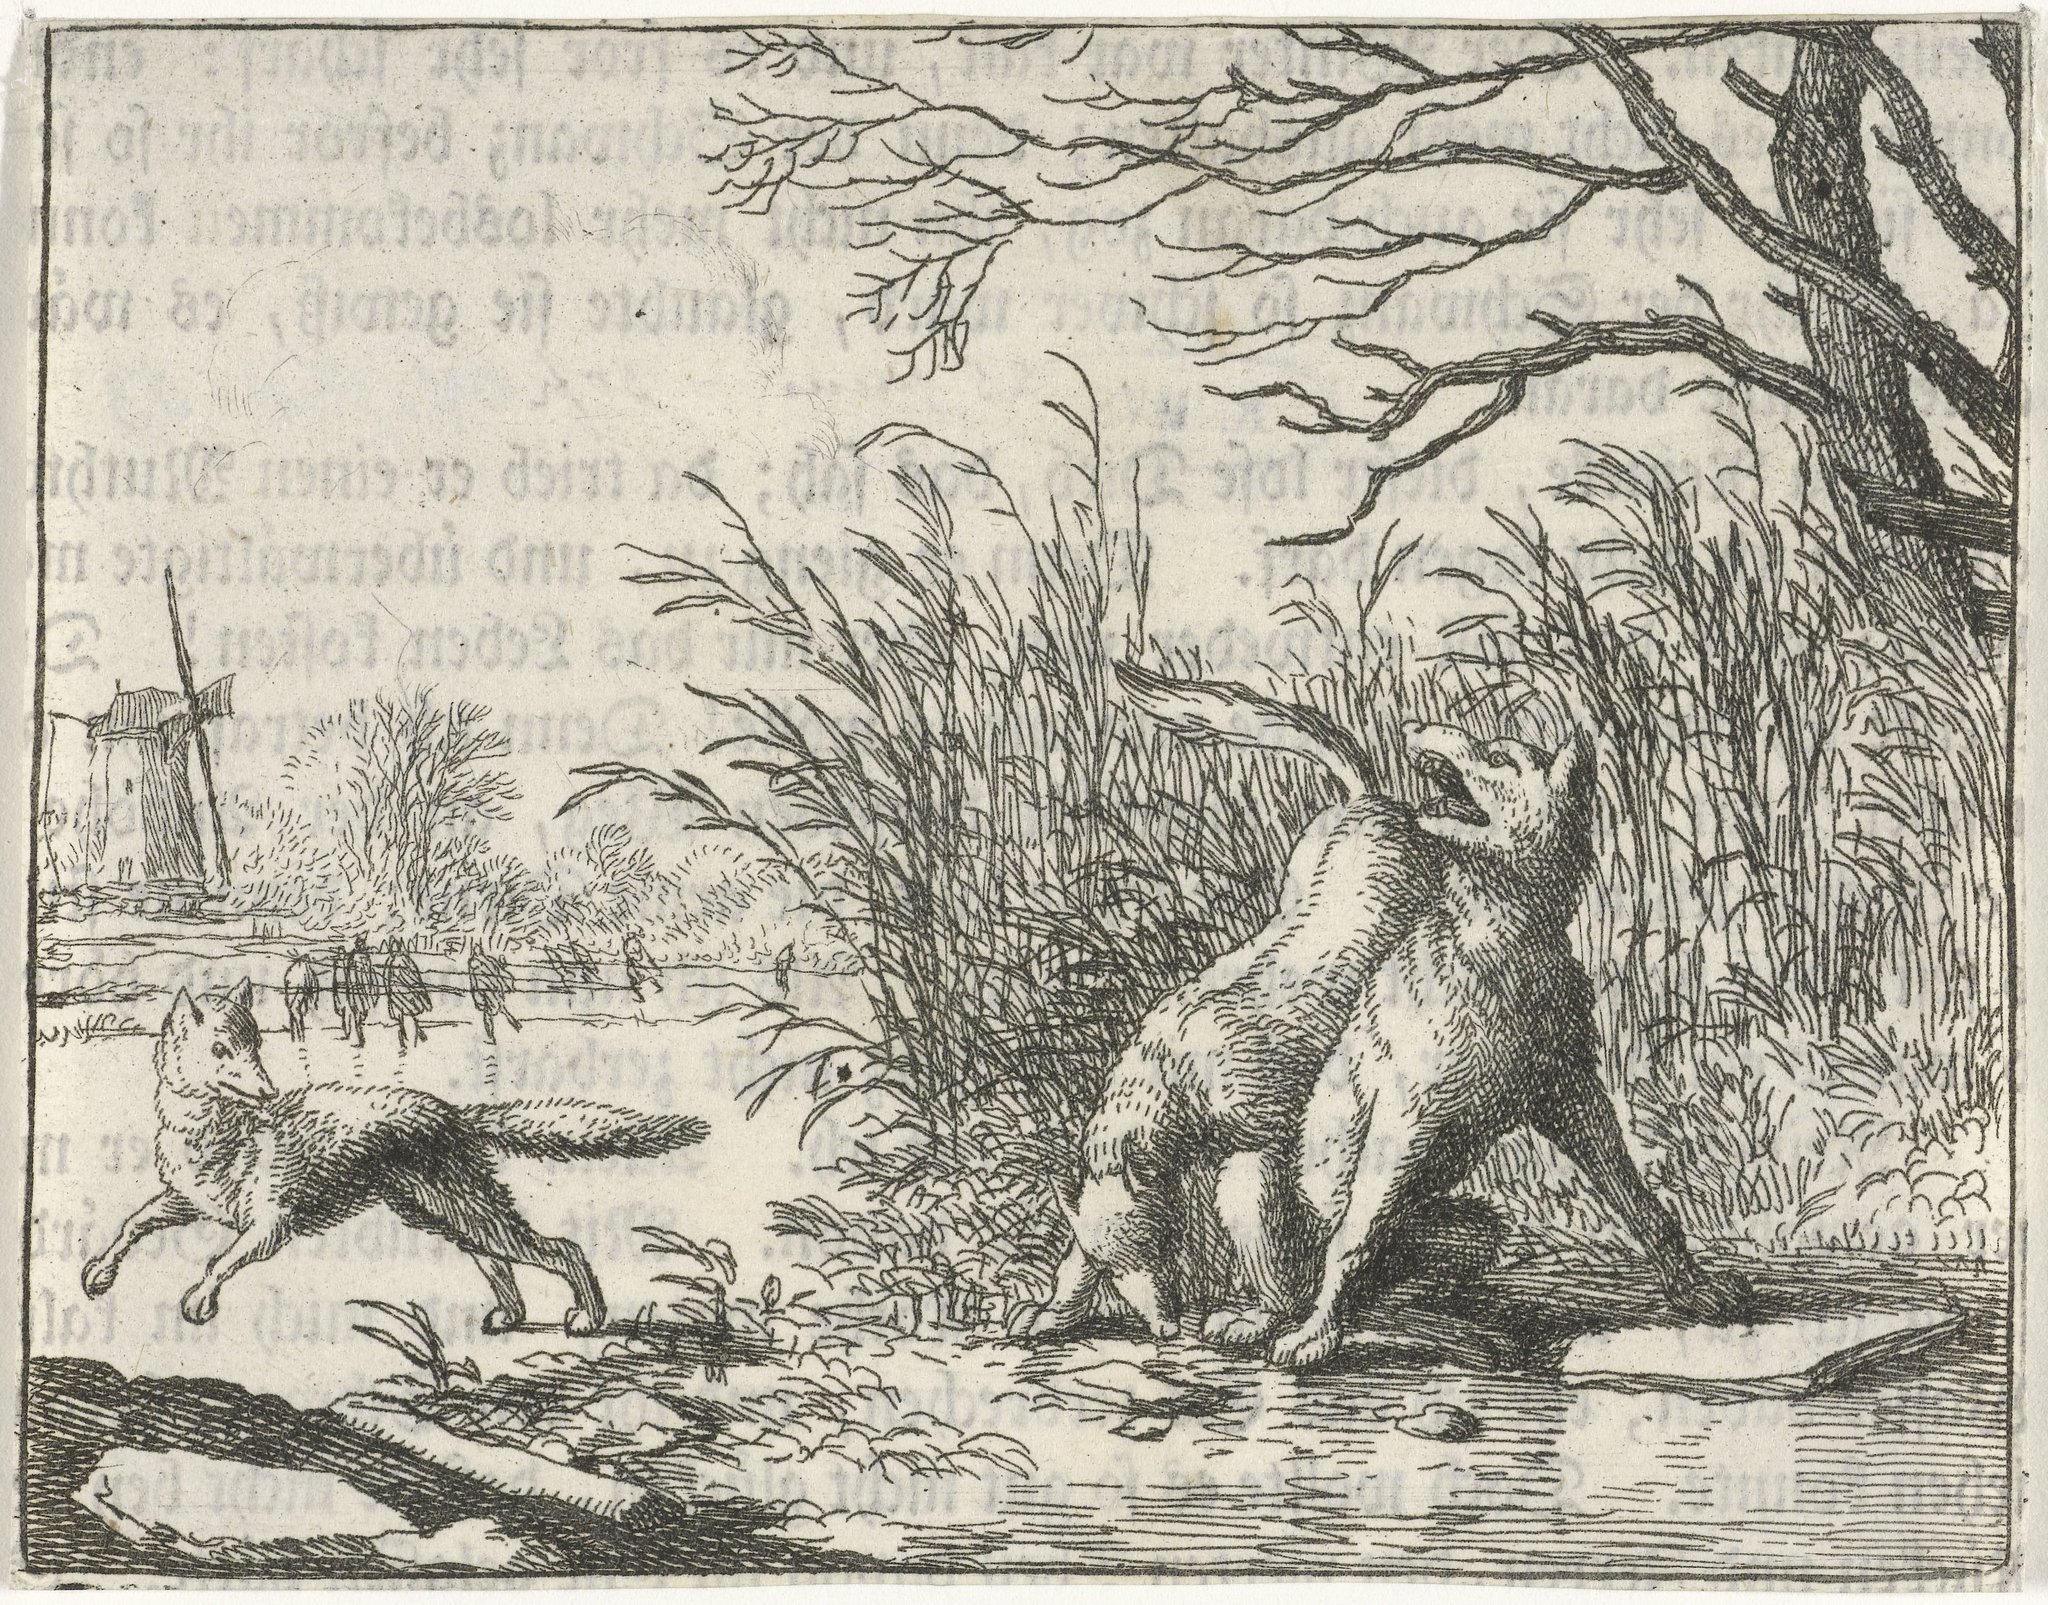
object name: book illustration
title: Reinaert de vos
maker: allaert van everdingen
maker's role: draughtsman, painter, print maker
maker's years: 1621-1675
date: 1665-1675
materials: paper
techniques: etching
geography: netherlands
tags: beasts of prey, predatory animals: wolf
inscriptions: collector's mark: Lugt 2228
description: Een vos heeft zijn snuit bij de poot van een huilende wolf. Op het bevroren water rent een tweede vos weg. Op de achterkant van de prent een Duits tekstfragment uit het verhaal van Reinaert de vos.